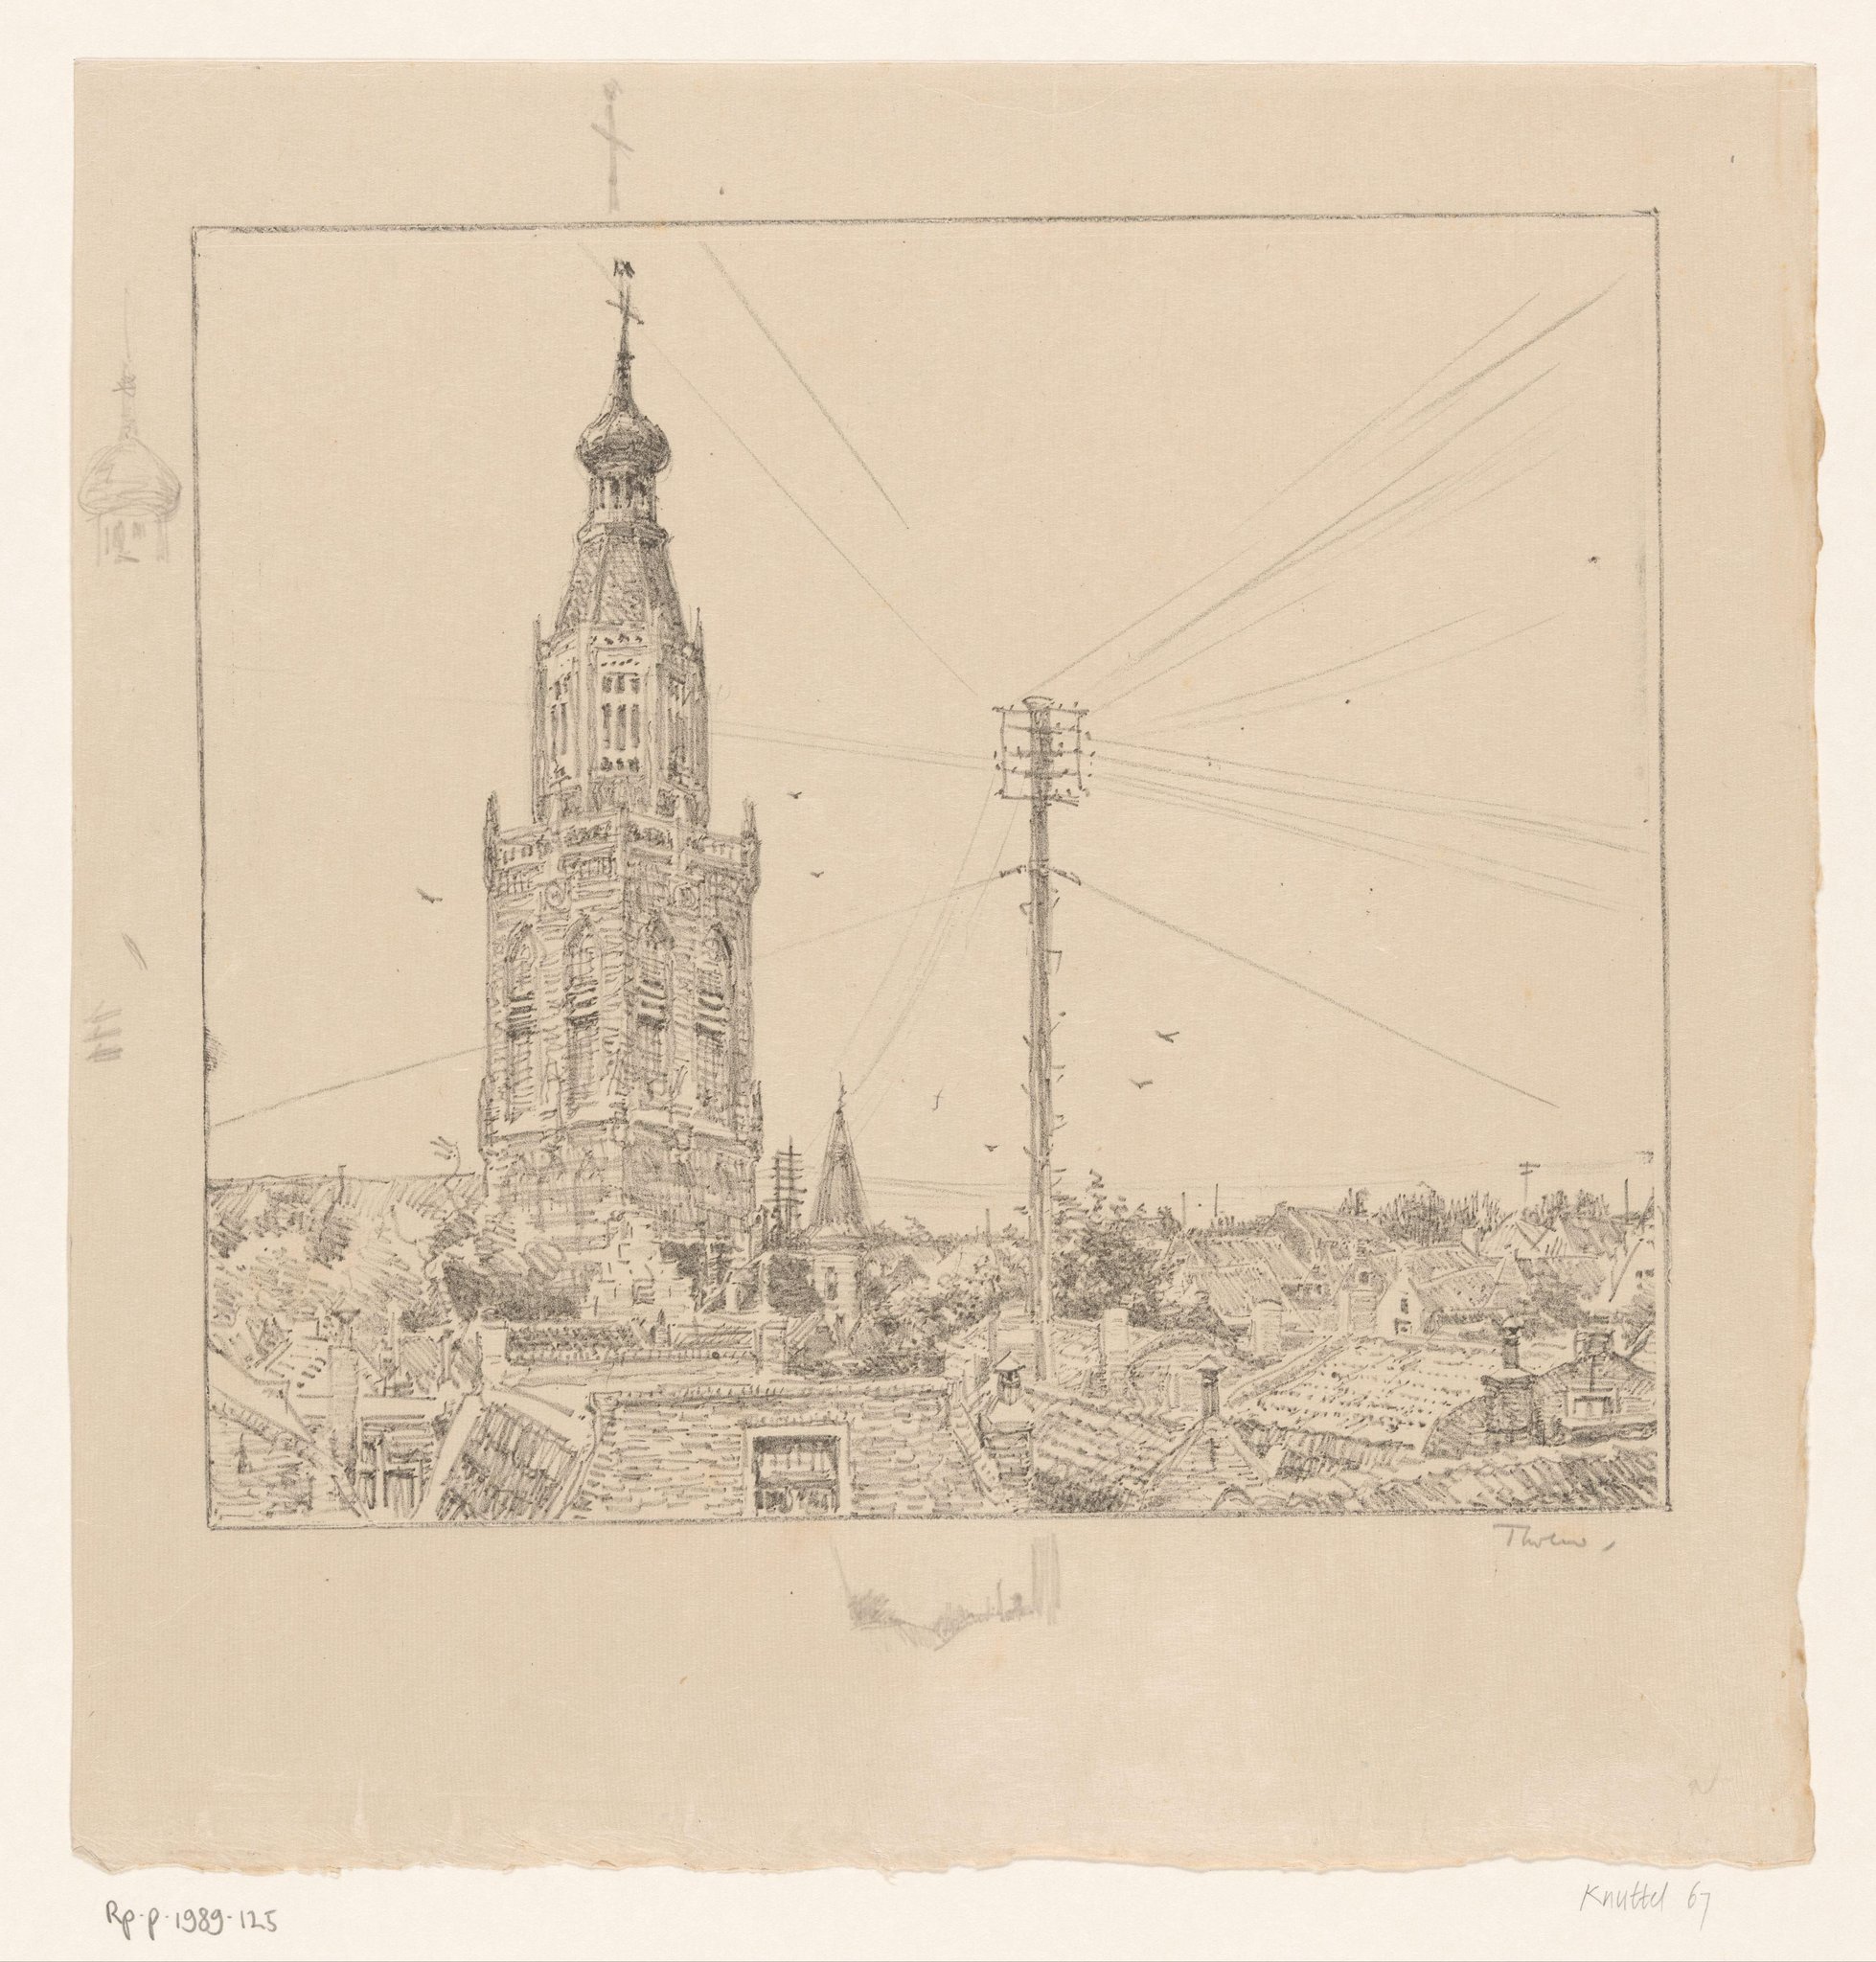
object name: print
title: Gezicht op Enkhuizen met de toren van de Zuiderkerk en een telefoonmast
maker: willem bastiaan tholen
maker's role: draughtsman, painter, print maker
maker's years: 1860-1931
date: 1905-1920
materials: paper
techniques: lithograph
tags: telegraph pole, telephone pole, church (exterior), prospect of city, town panorama, silhouette of city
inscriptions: collector's mark: Lugt 2228, collector's mark: Lugt 2760